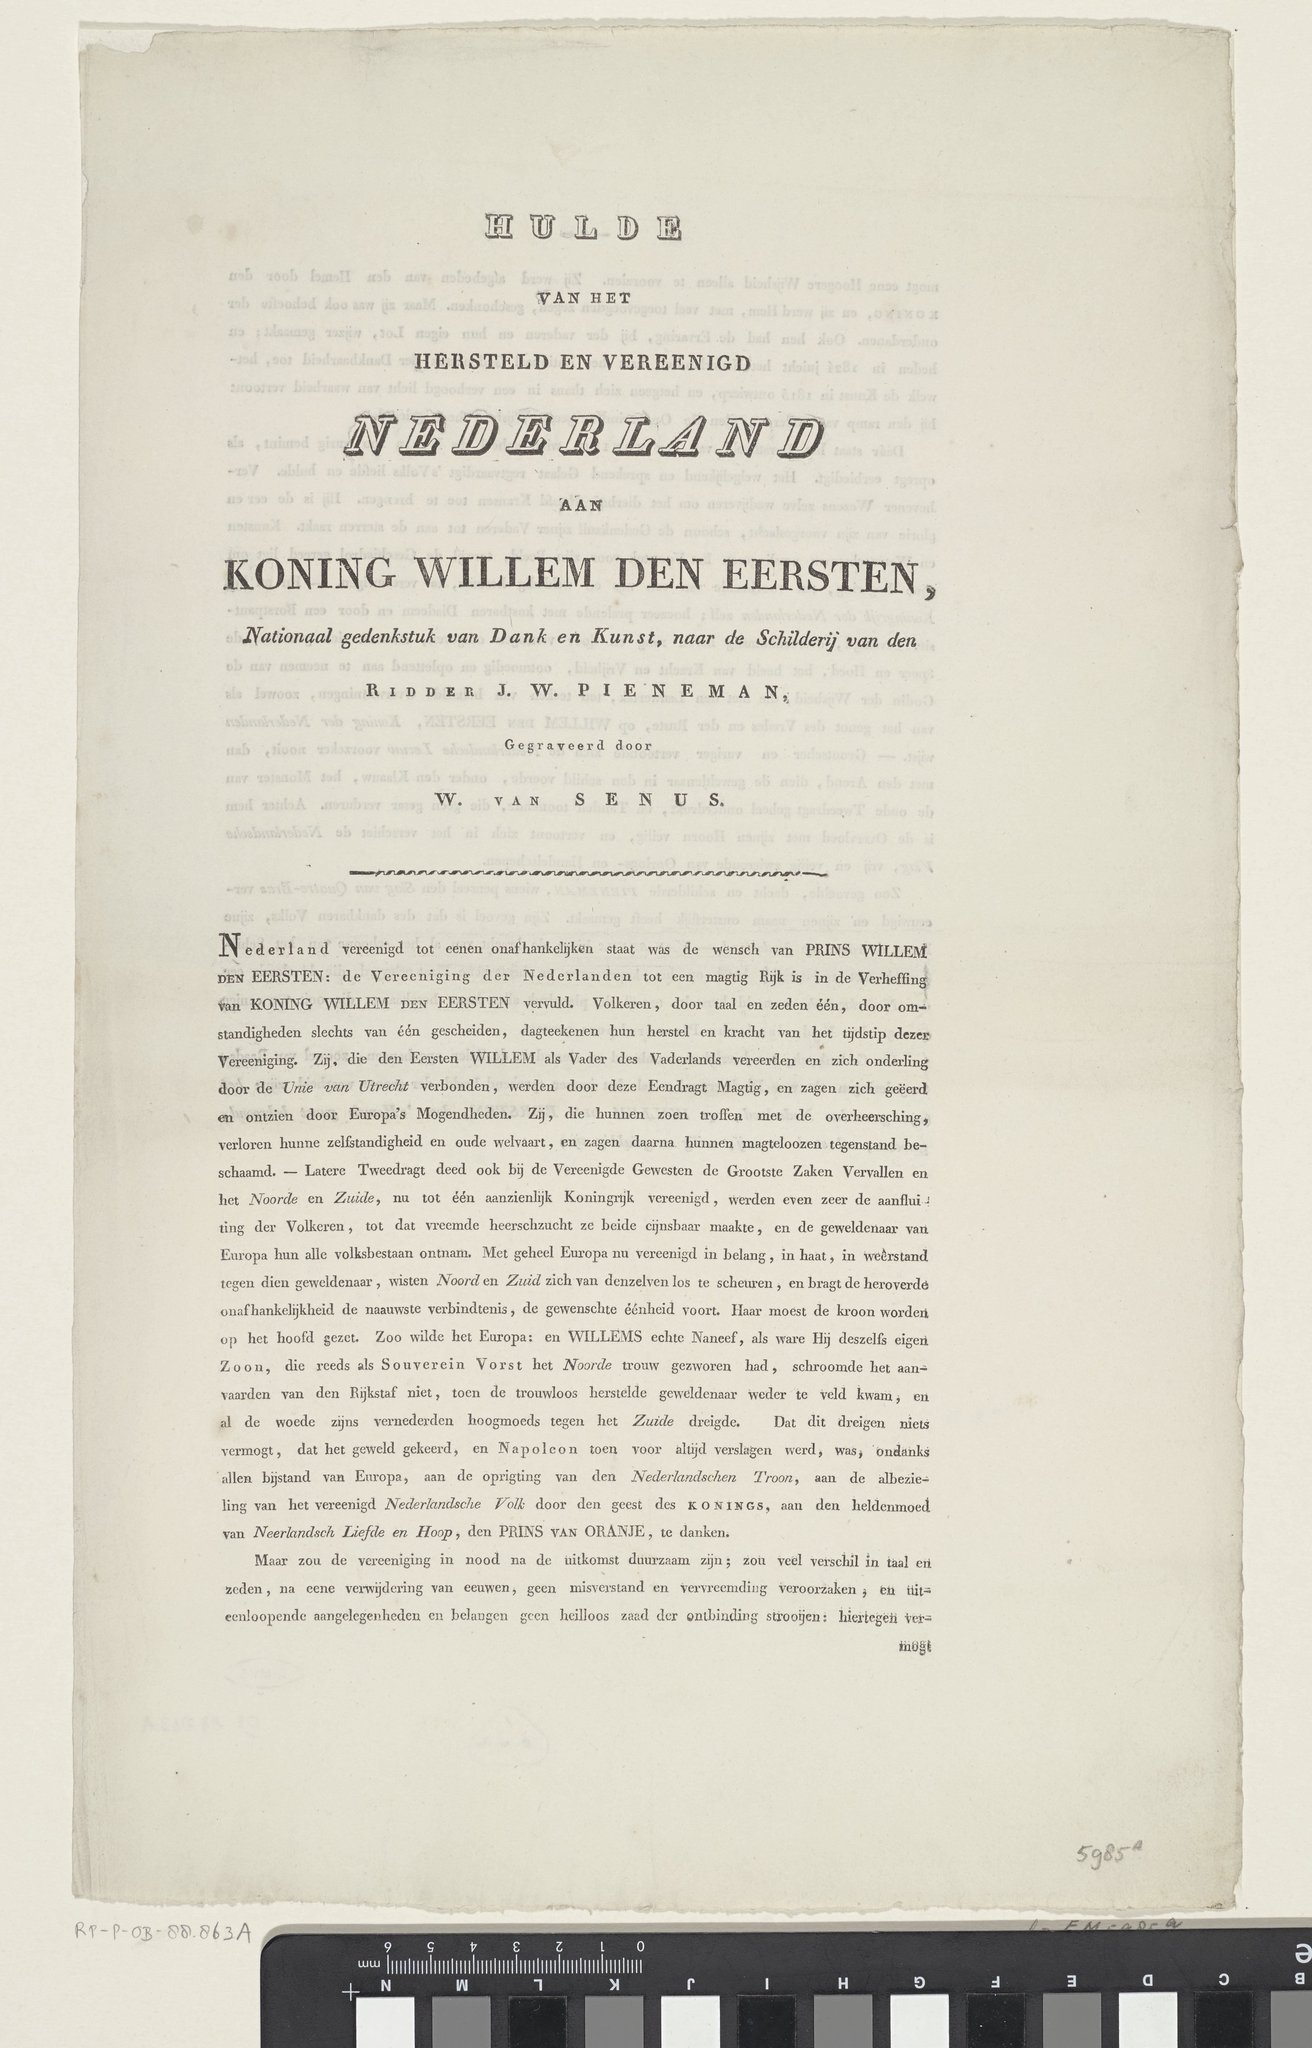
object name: text sheet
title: Verklaring bij de prent met het huldeblijk aan koning Willem I, 1815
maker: Anonymous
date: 1815-1816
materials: paper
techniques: letterpress printing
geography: netherlands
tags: the hague, berlin, william i of the netherlands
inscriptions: collector's mark: Lugt 2228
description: Gedrukte verklaring bij de prent met de allegorische voorstelling waarin de knielende Nederlandse Maagd de speer met de hoed van de vrijheid in ontvangst neemt van Minerva. Ter gelegenheid van de inhuldiging van Willem I te Brussel in 1815. Blad bedrukt op beide zijden.